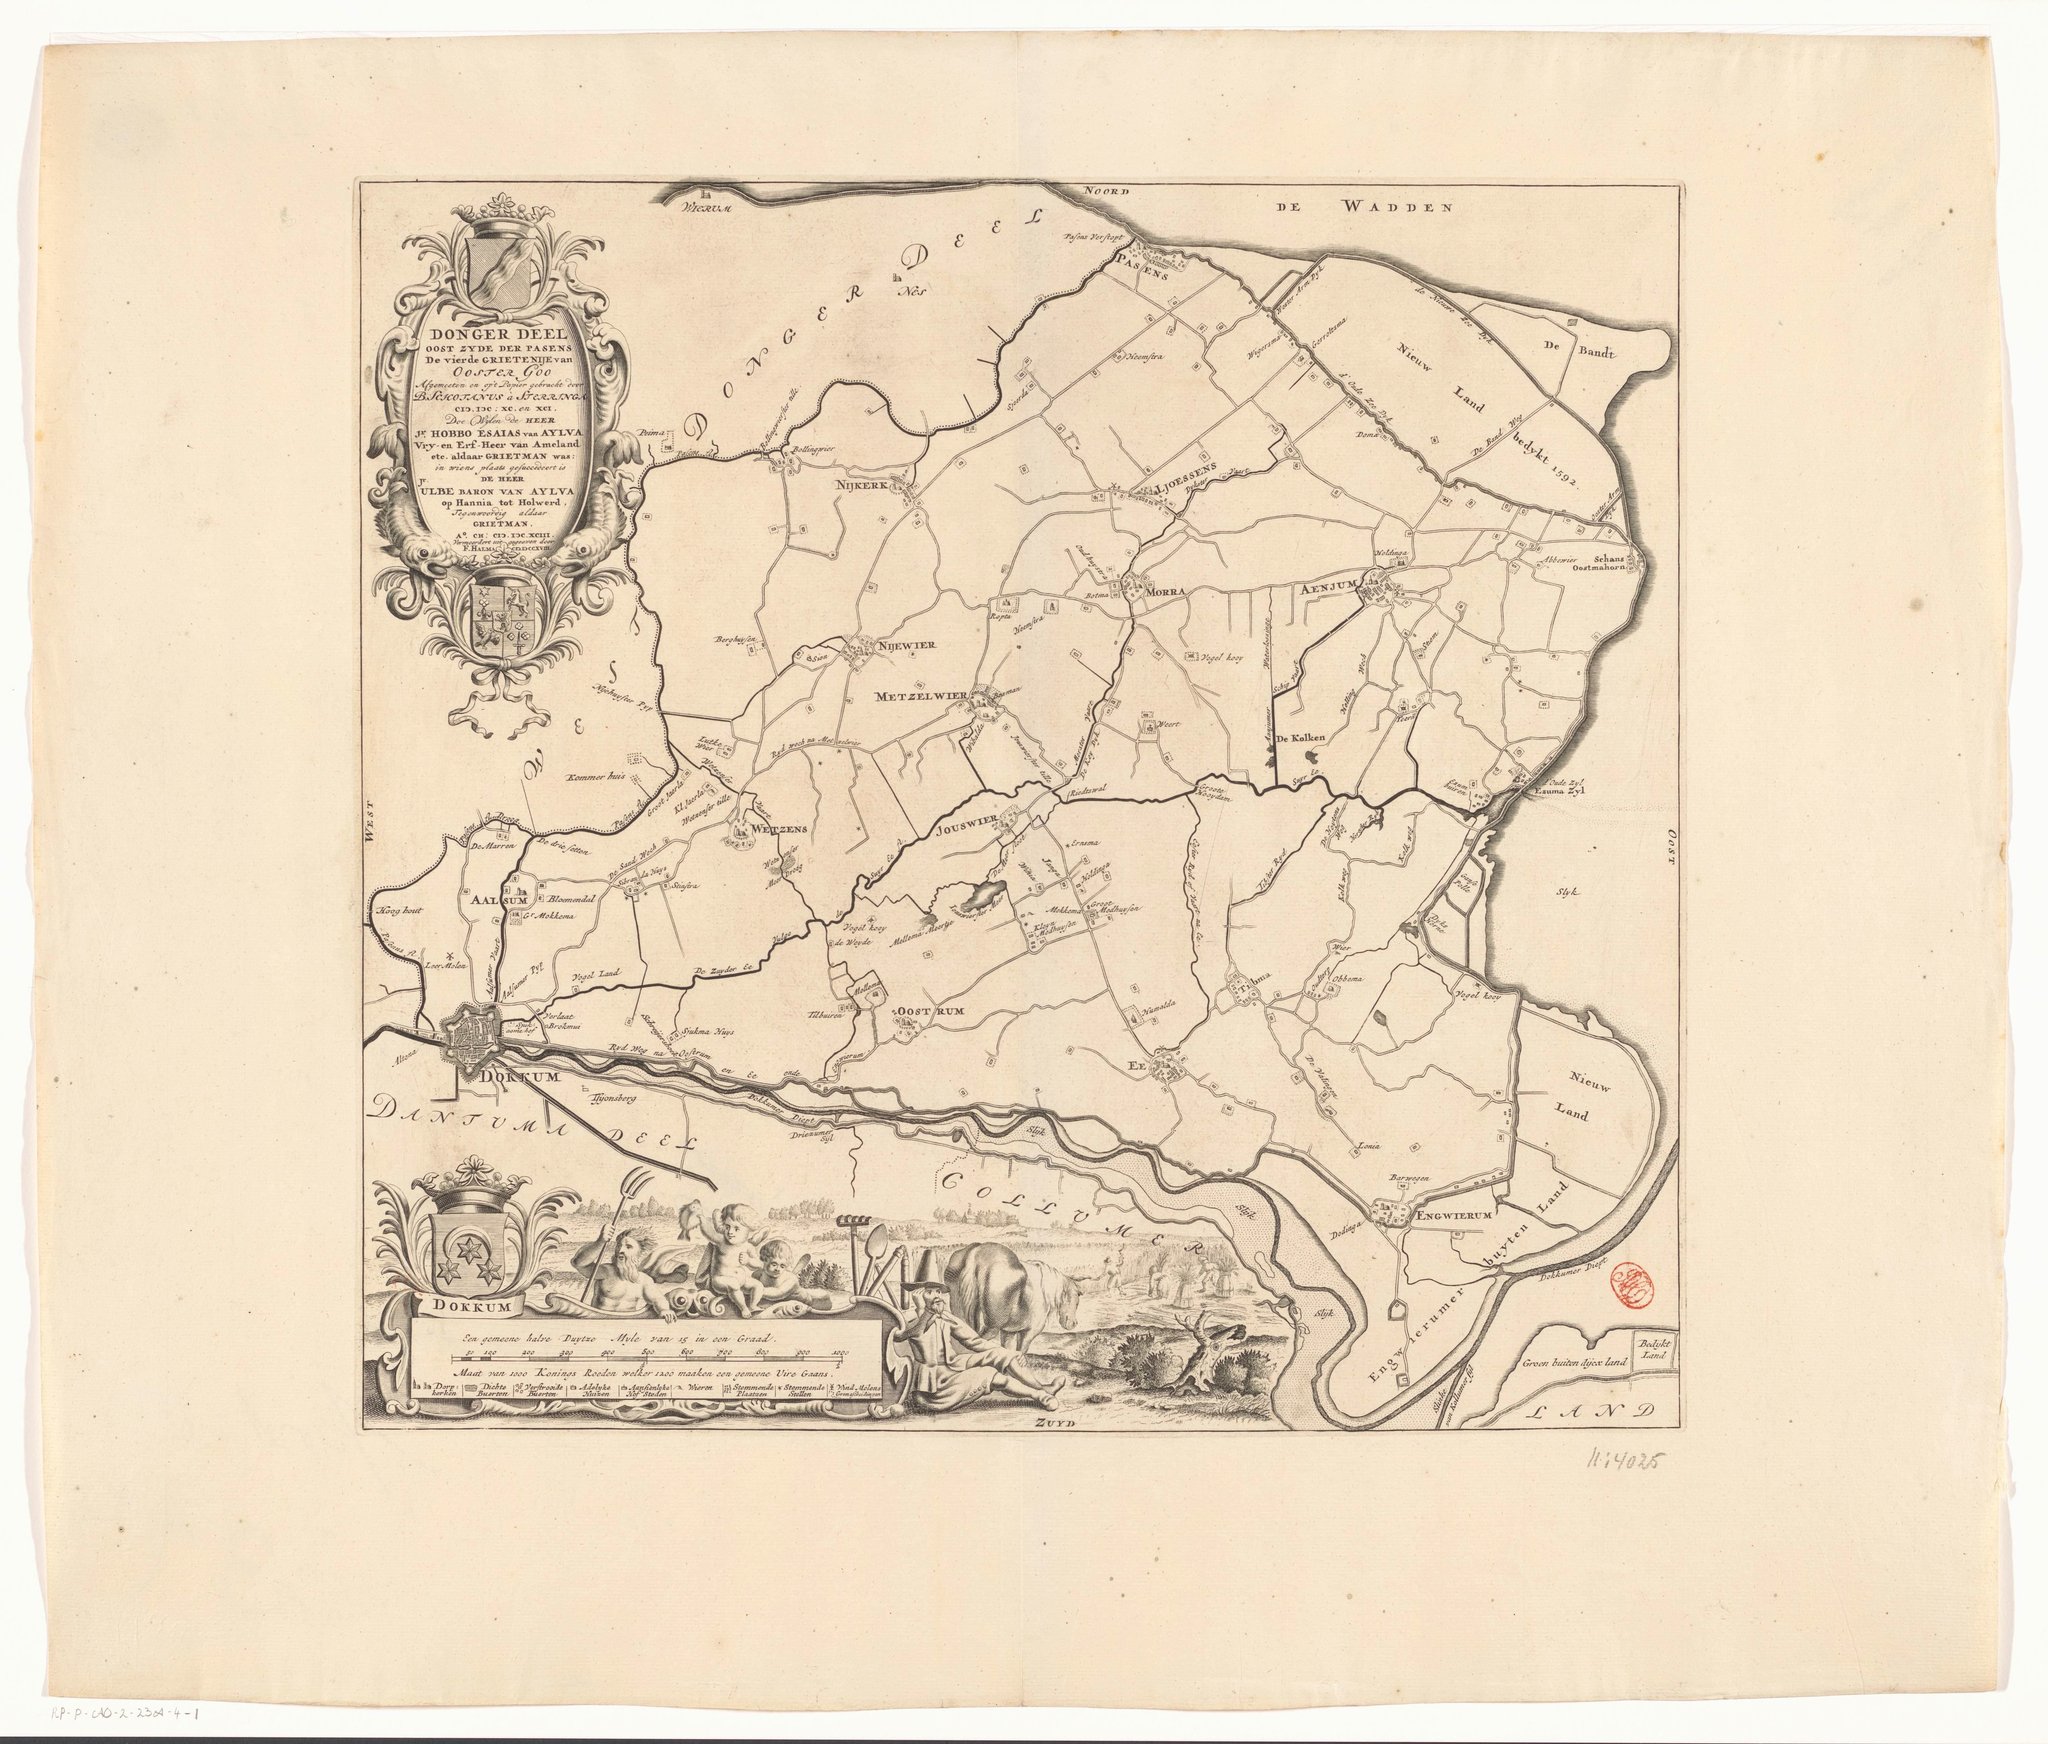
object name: print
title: Kaart van de grietenij Oostdongeradeel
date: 1698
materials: paper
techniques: engraving, etching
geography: amsterdam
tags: (story of) neptune (poseidon), coat of arms (as symbol of the state, etc.), maps of separate countries or regions, farmers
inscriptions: collector's mark: Lugt 2228, label: ‘264’, collector's mark: Lugt 195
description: Linksboven cartouche met titel, bestuurlijke informatie over de grietenij en de wapens van Oostdongeradeel en van grietman jonker Ulbe baron van Aylva. Linksonder cartouche met legenda en een schaalstok: Een gemeene halve Duytze myle van 15 in een graad - Maat van 1000 konings roeden welker 1200 maaken een gemeene uire gaans. Daaromheen het wapen van de stad Dokkum, Neptunus, twee putti en een landbouwer.